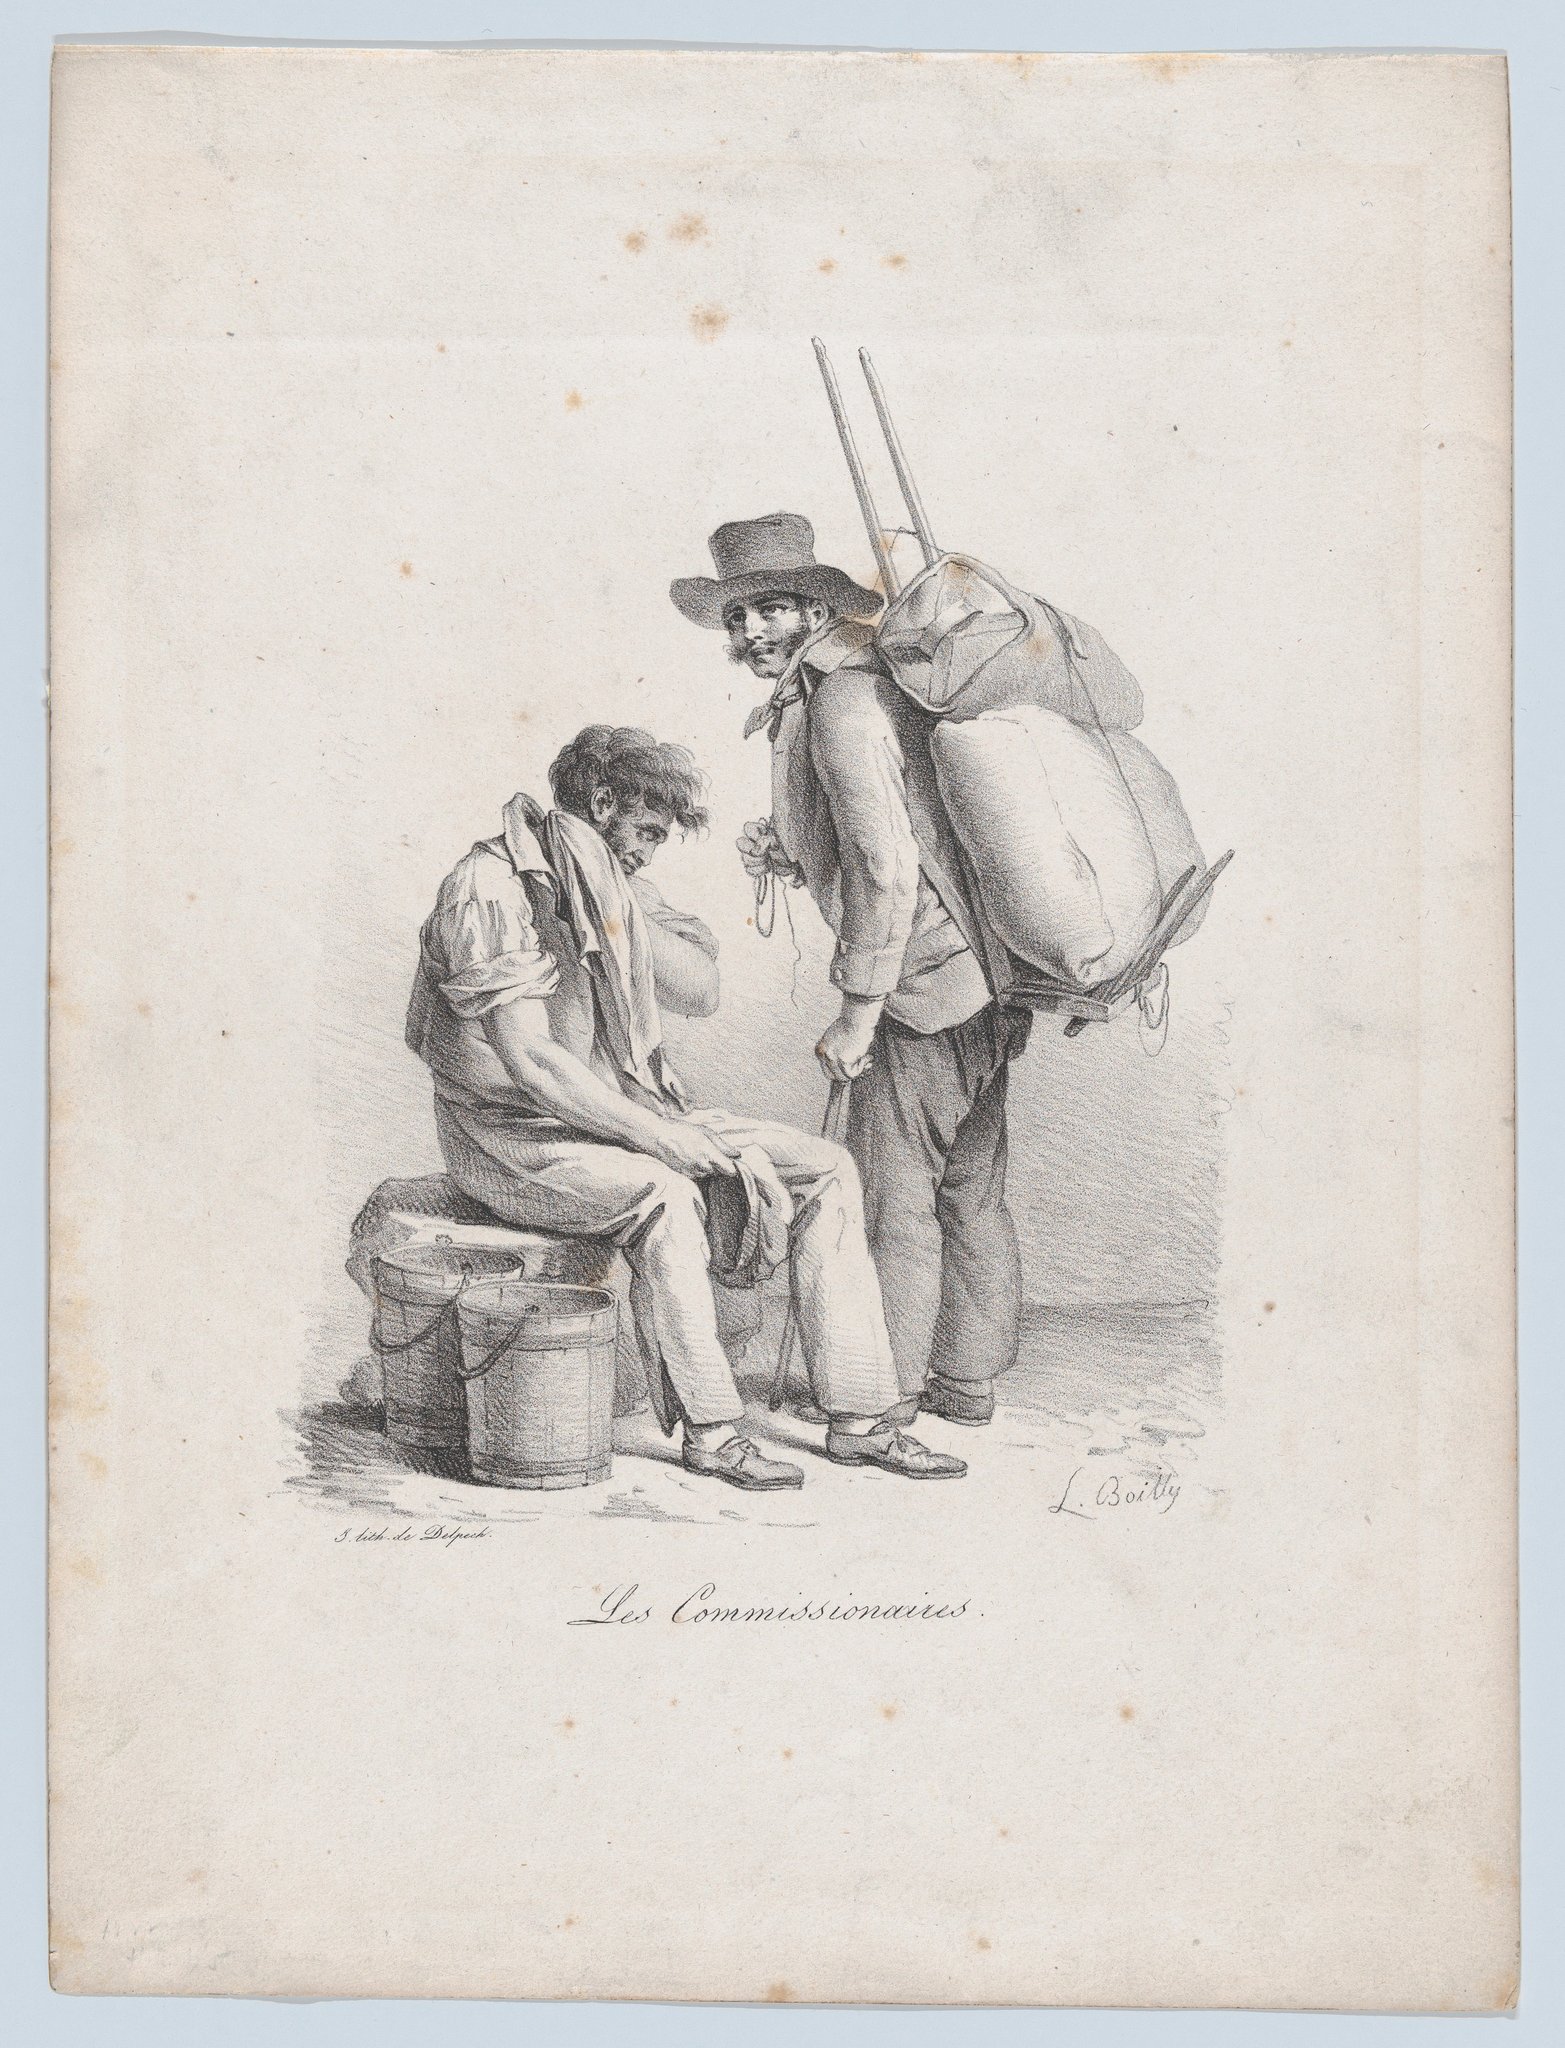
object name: print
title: Hired Hands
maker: louis léopold boilly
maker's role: artist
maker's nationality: french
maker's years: 1761-1845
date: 1822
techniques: lithograph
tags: men